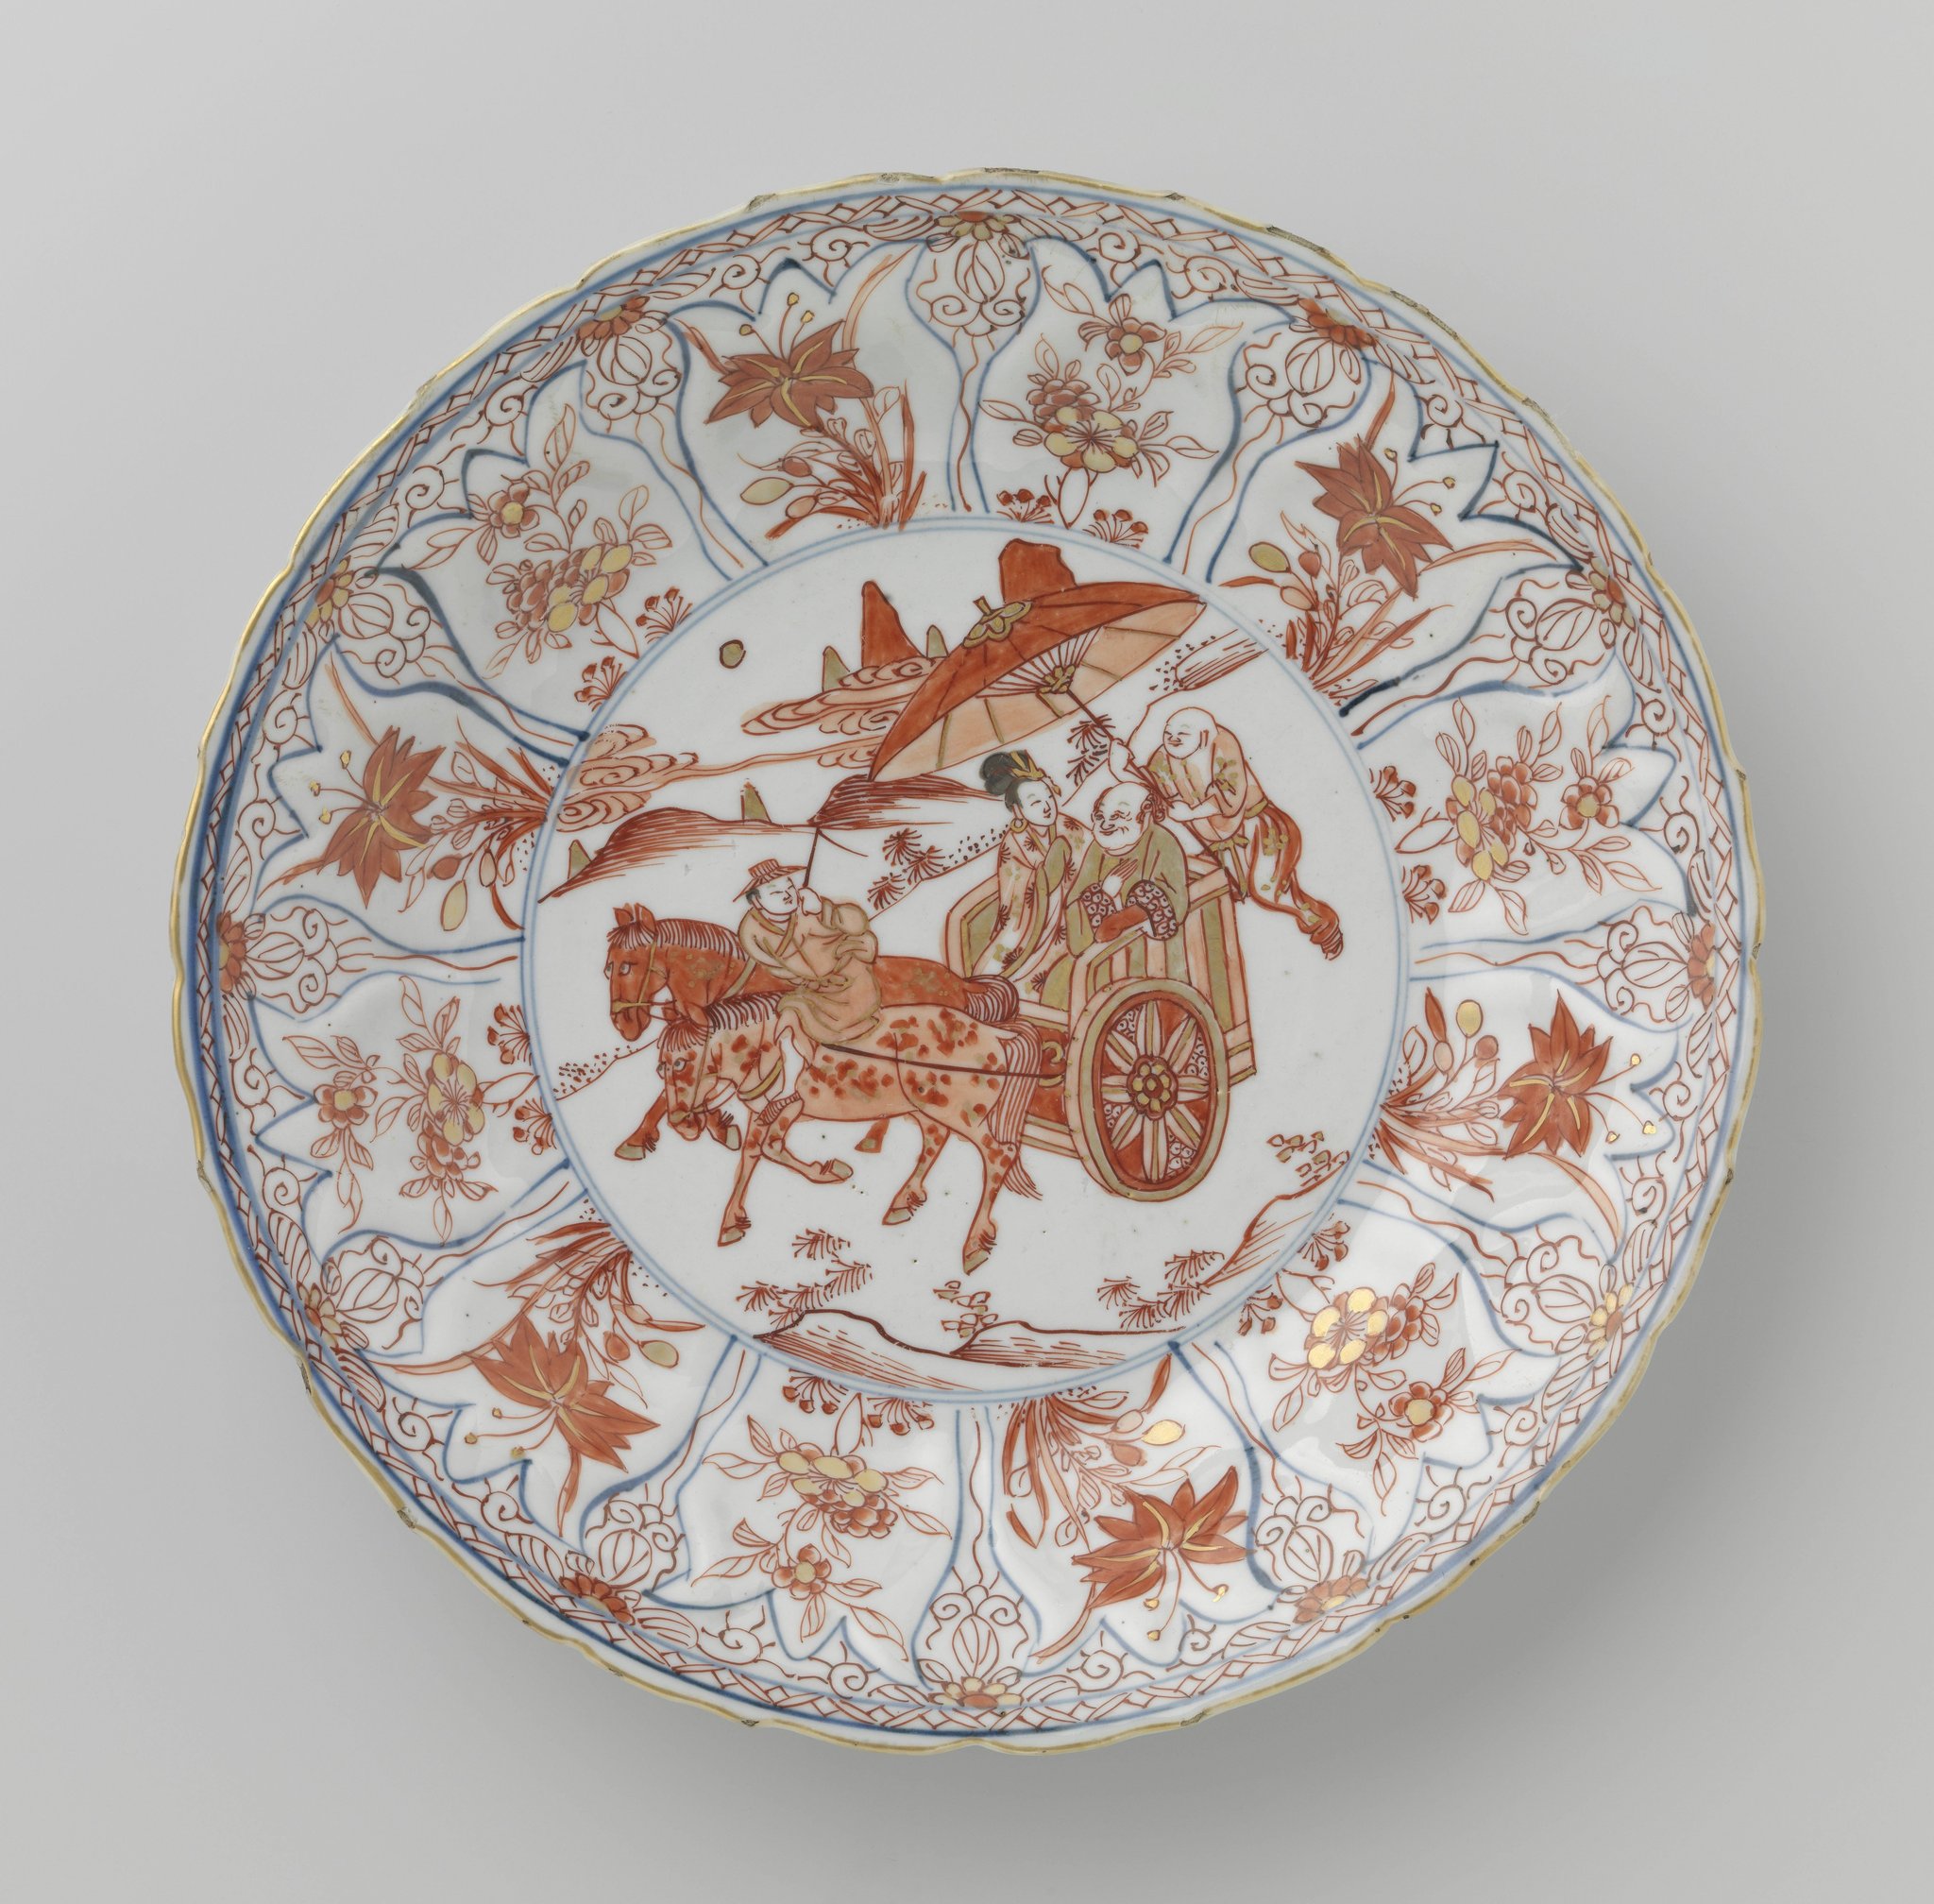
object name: platter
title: Saucer-dish with a couple in a cart with two servants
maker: Anonymous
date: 1700-1724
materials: cobalt, glaze, gold, paint, porcelain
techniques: firing, gilding, turning, vitrification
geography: china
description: Schotel met een decor van een man en een vrouw in een door twee paarden getrokken wagen. Melk en bloed.